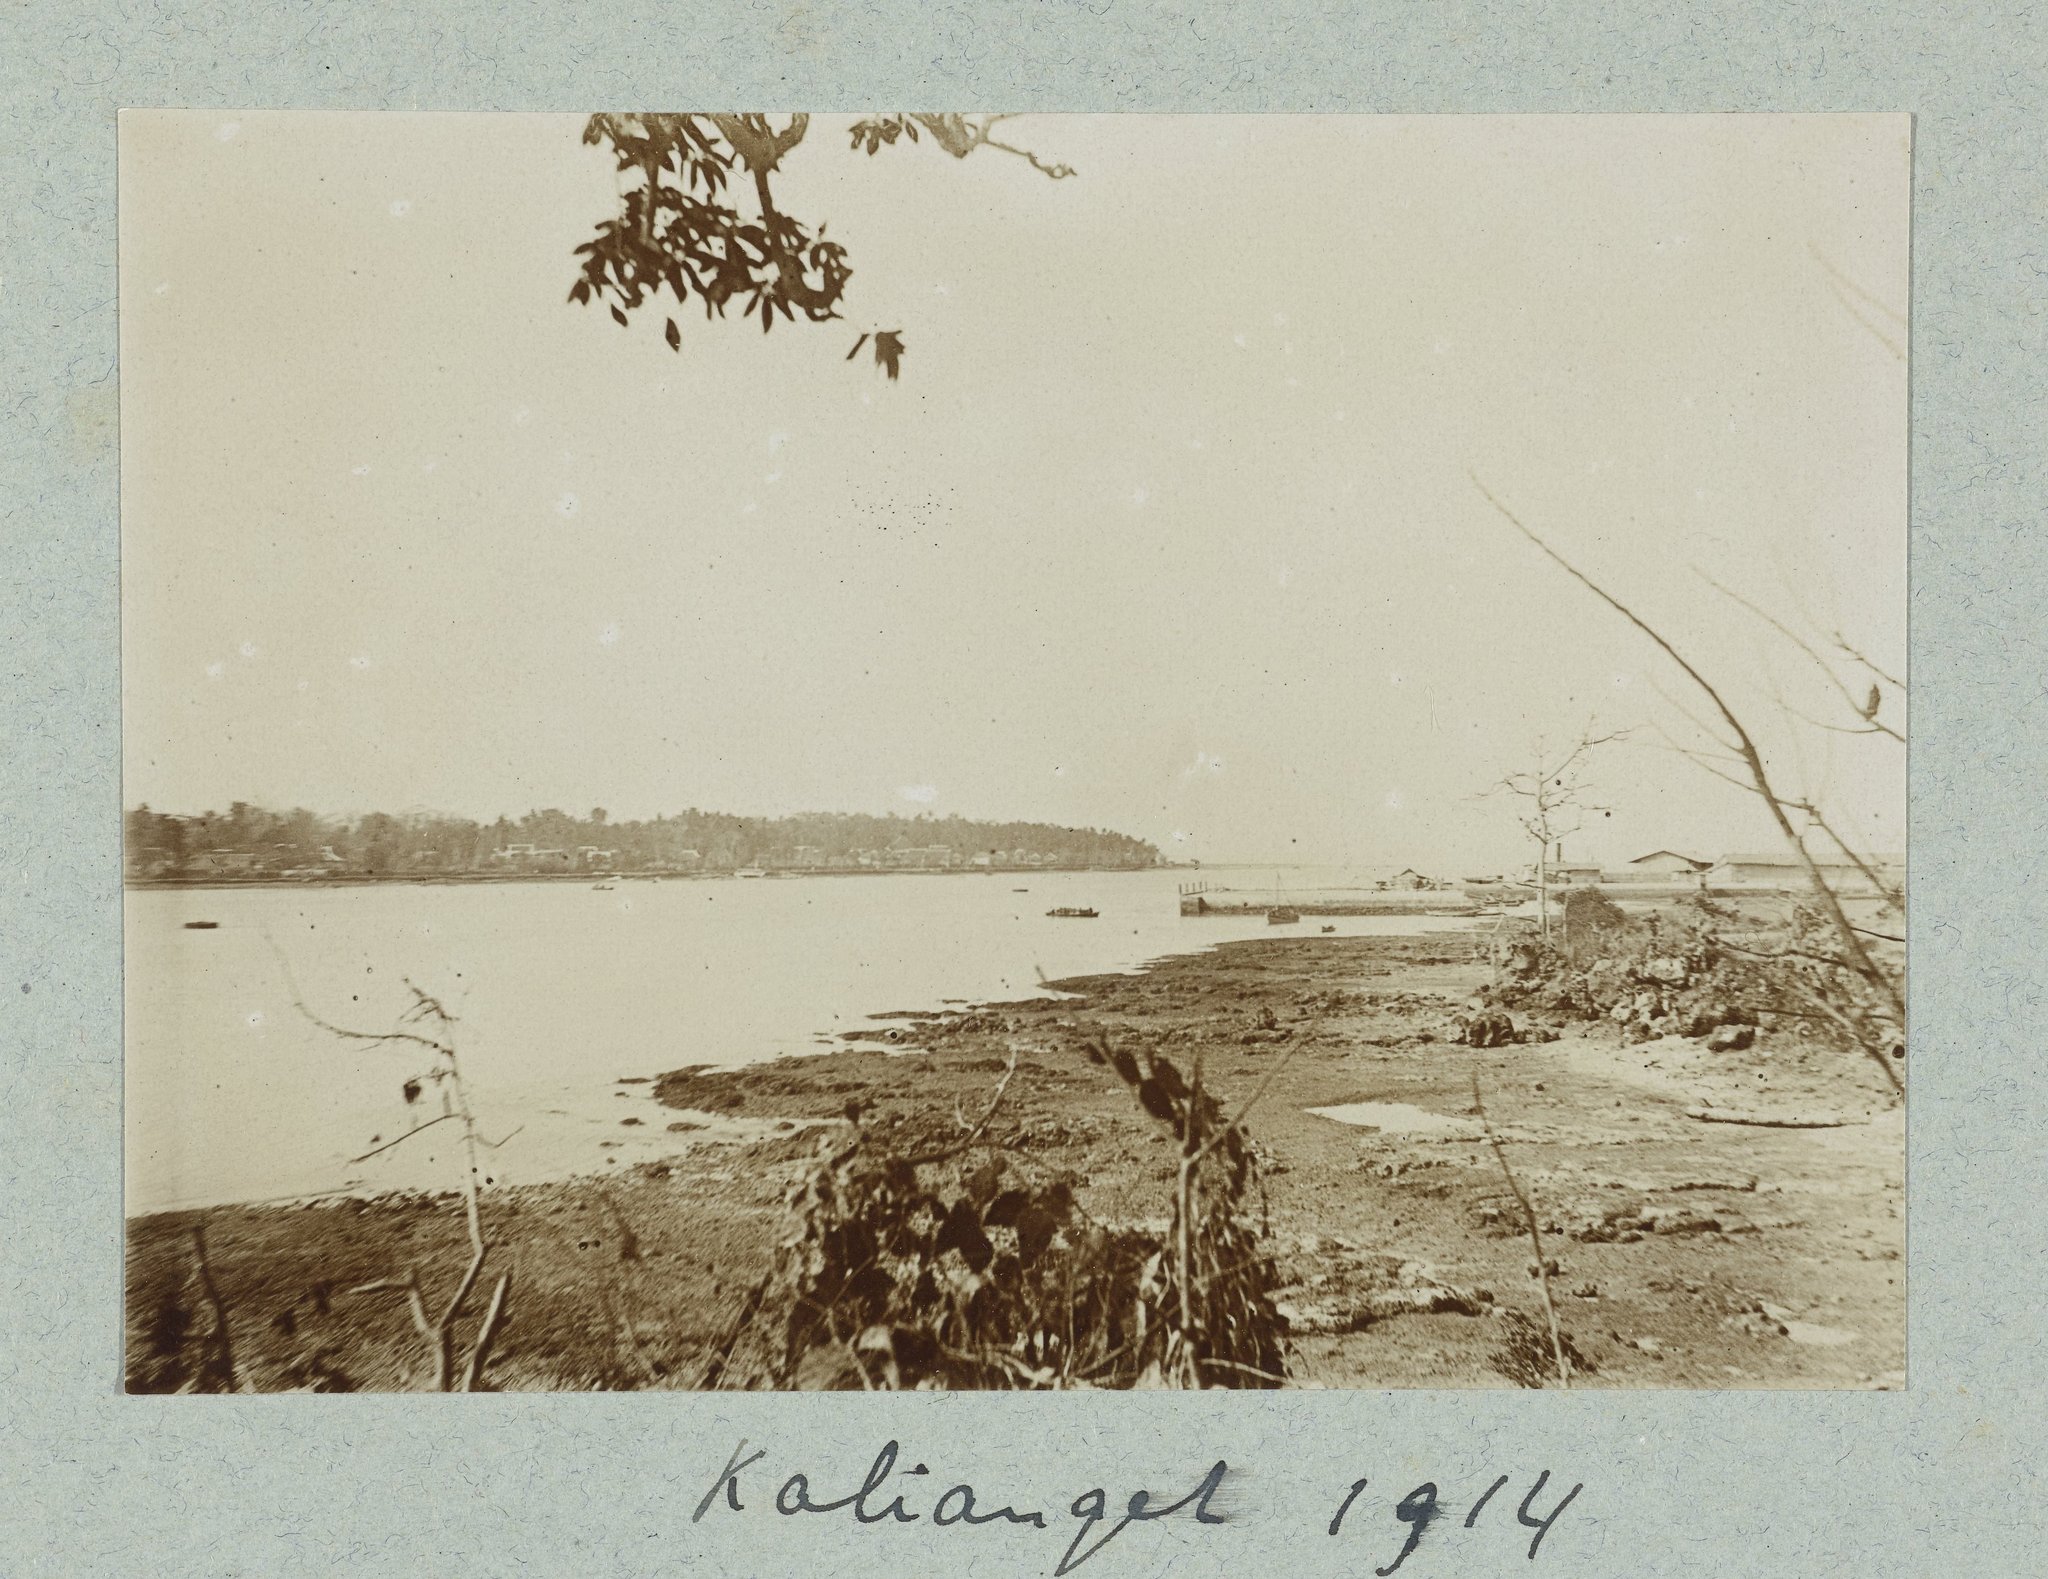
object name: photograph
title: Photographieën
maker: frits freerks fontein fz.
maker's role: fotograaf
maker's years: 1882-1928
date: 1912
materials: cardboard, paper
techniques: gelatin silver print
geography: madura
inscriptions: caption: ‘Kalianget 1914’